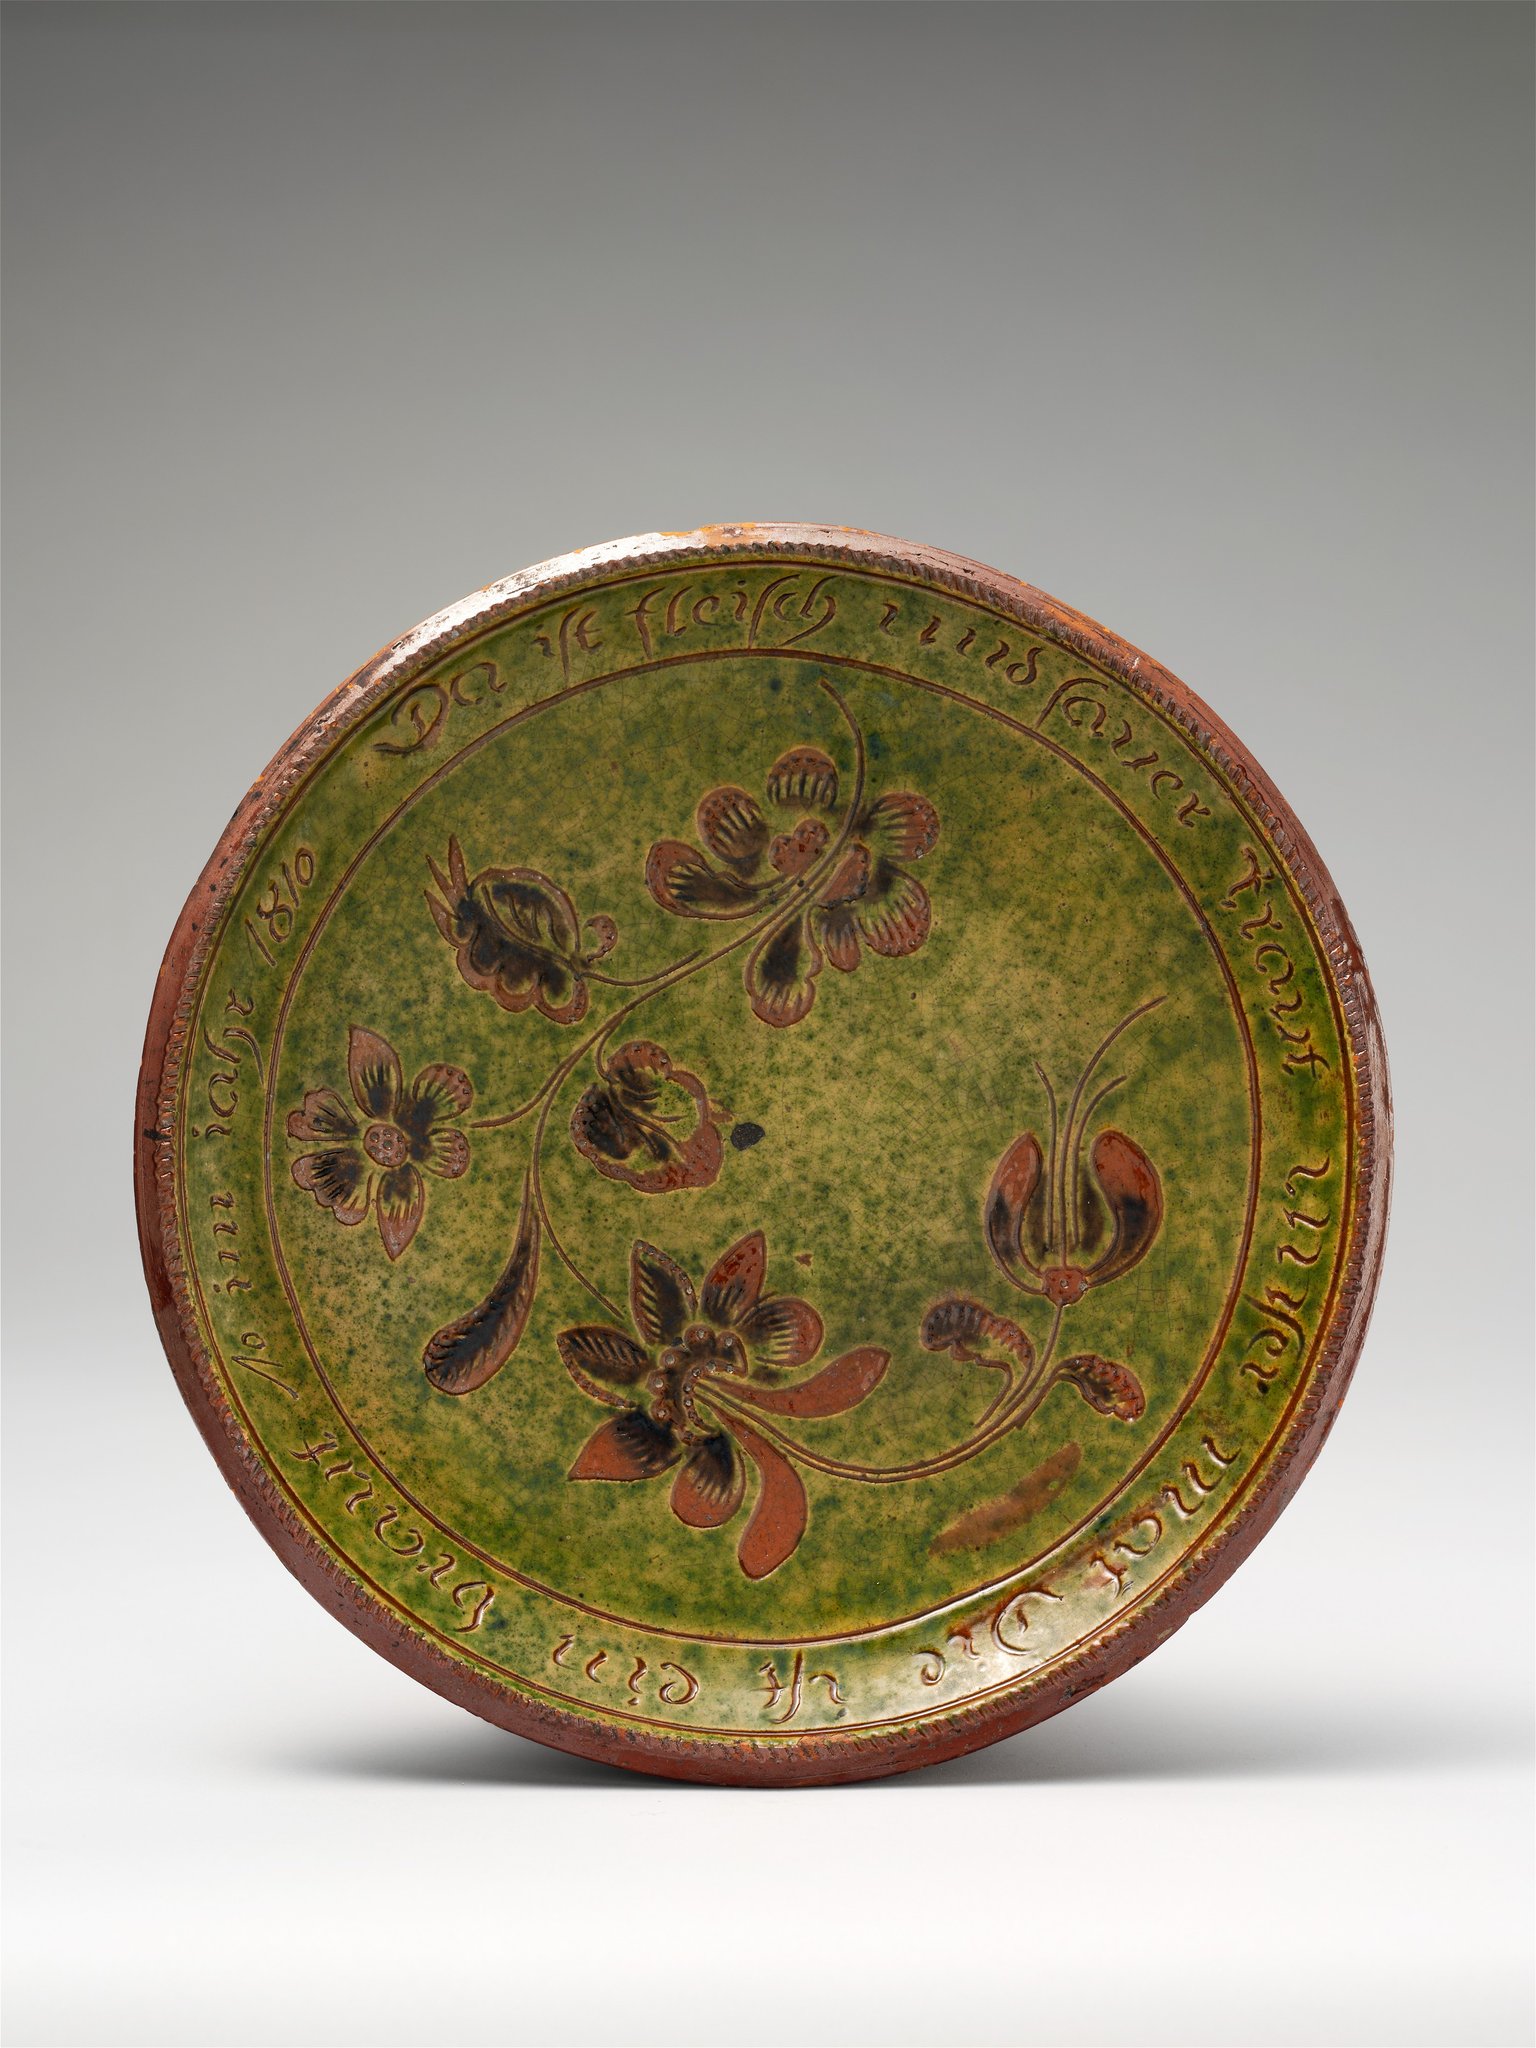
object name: plate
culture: american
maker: john neis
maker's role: maker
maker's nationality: american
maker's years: 1785-1867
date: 1810-1820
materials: earthenware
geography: united states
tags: flowers